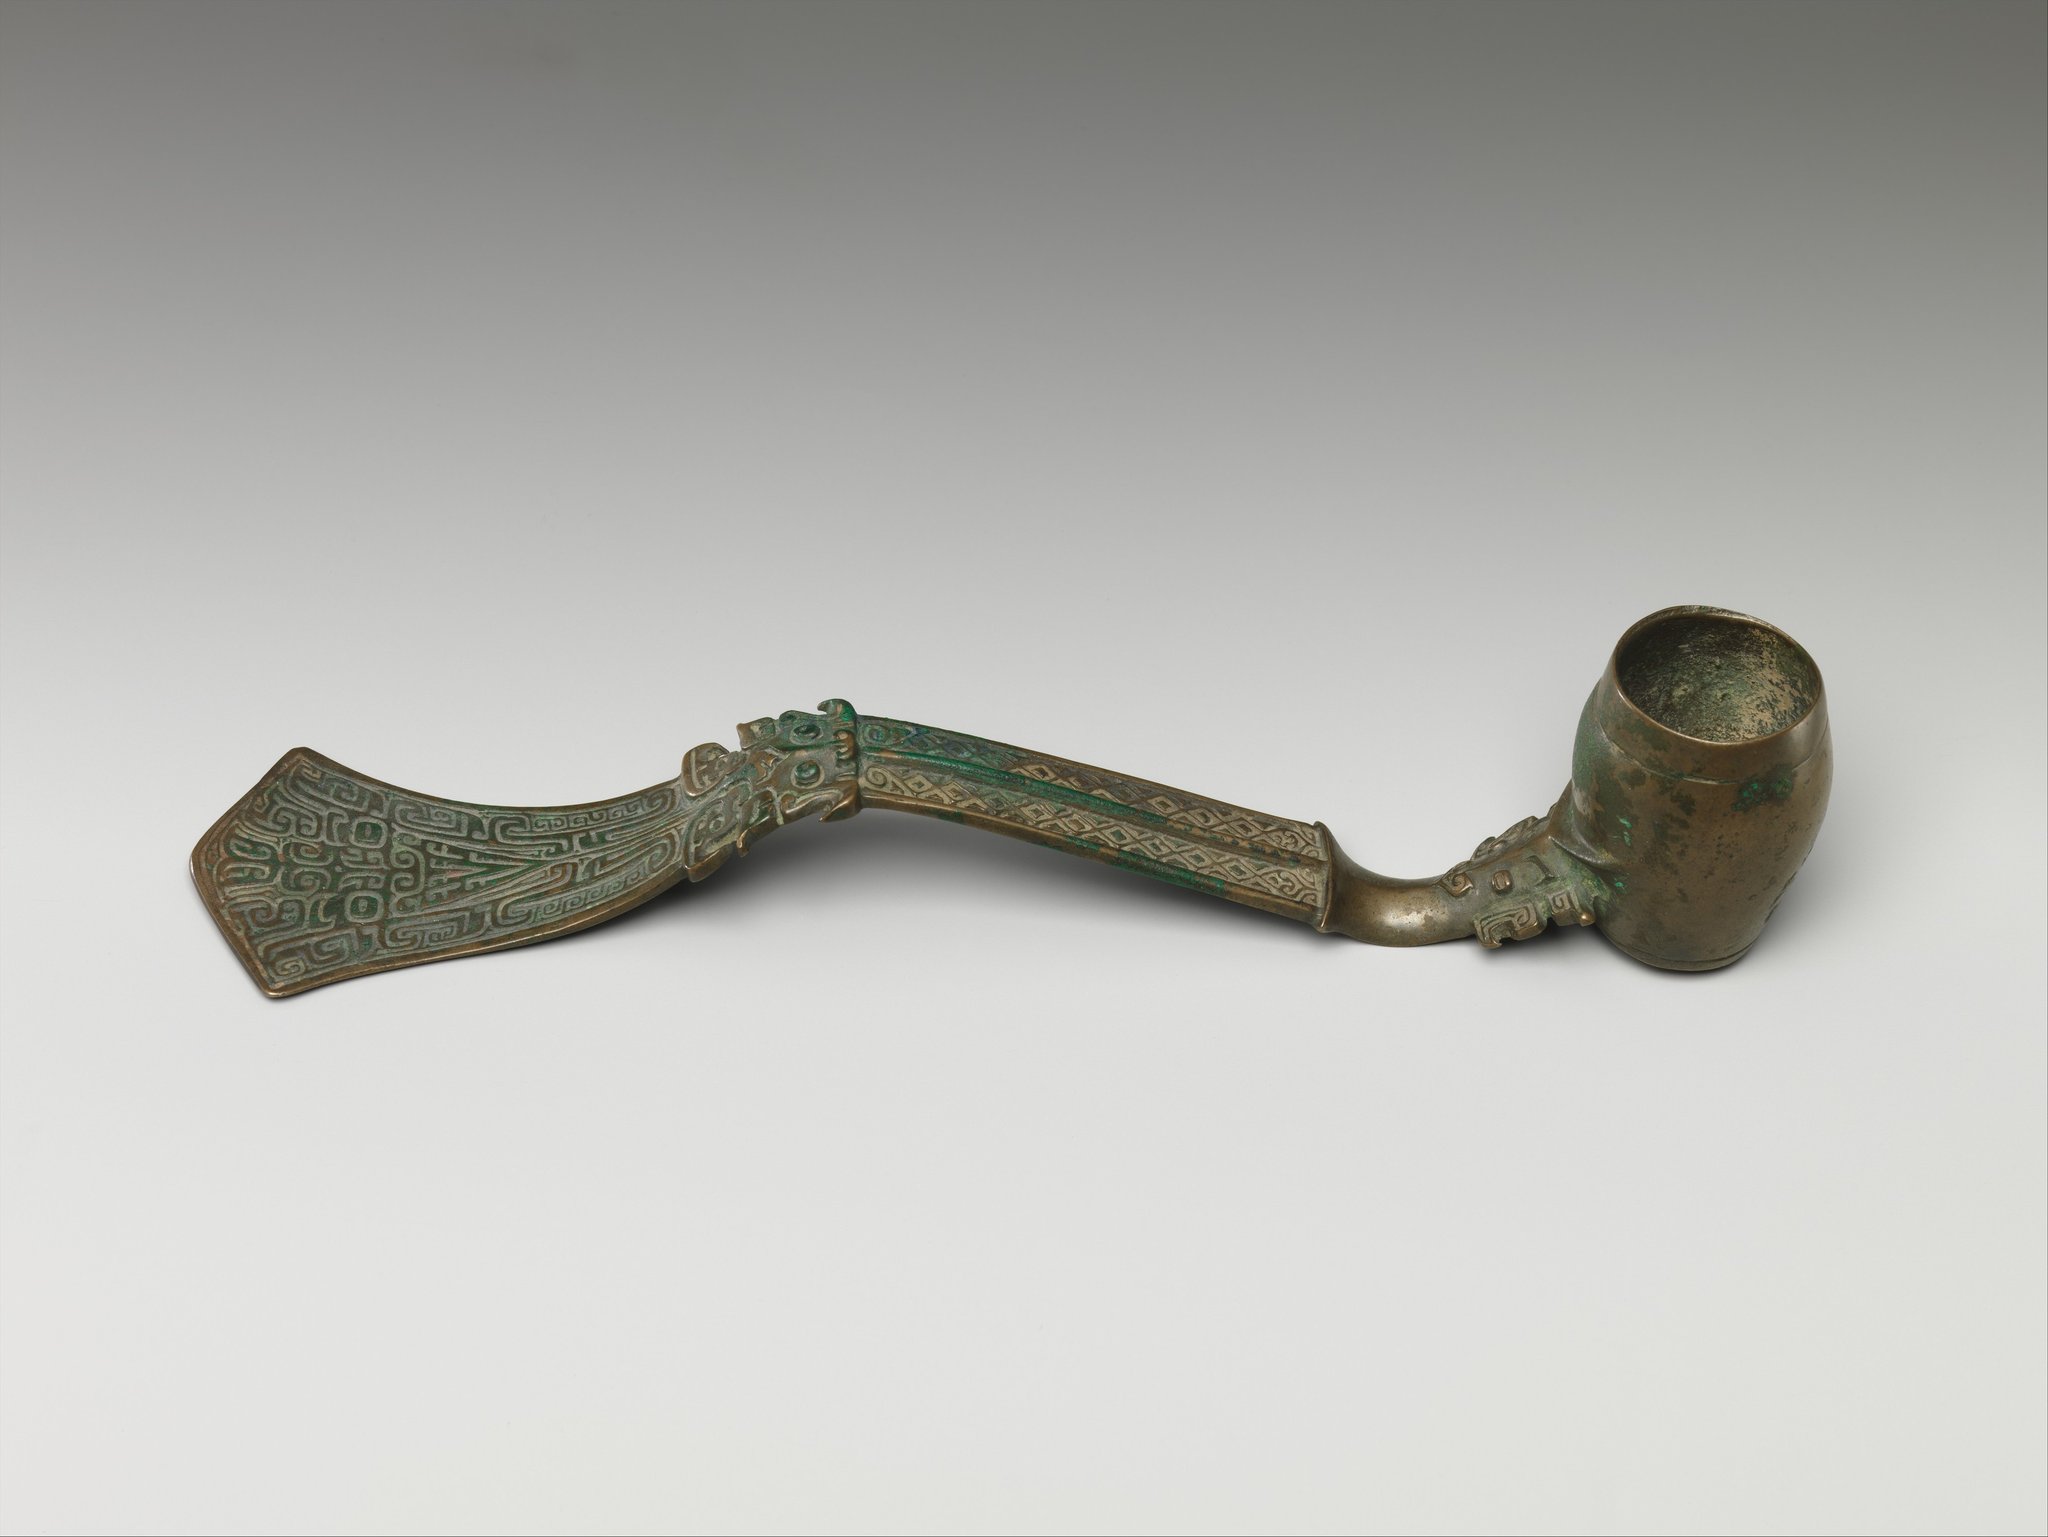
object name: ladle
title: Ritual ladle (Shao)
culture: chinese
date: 1034-1001 BCE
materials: bronze